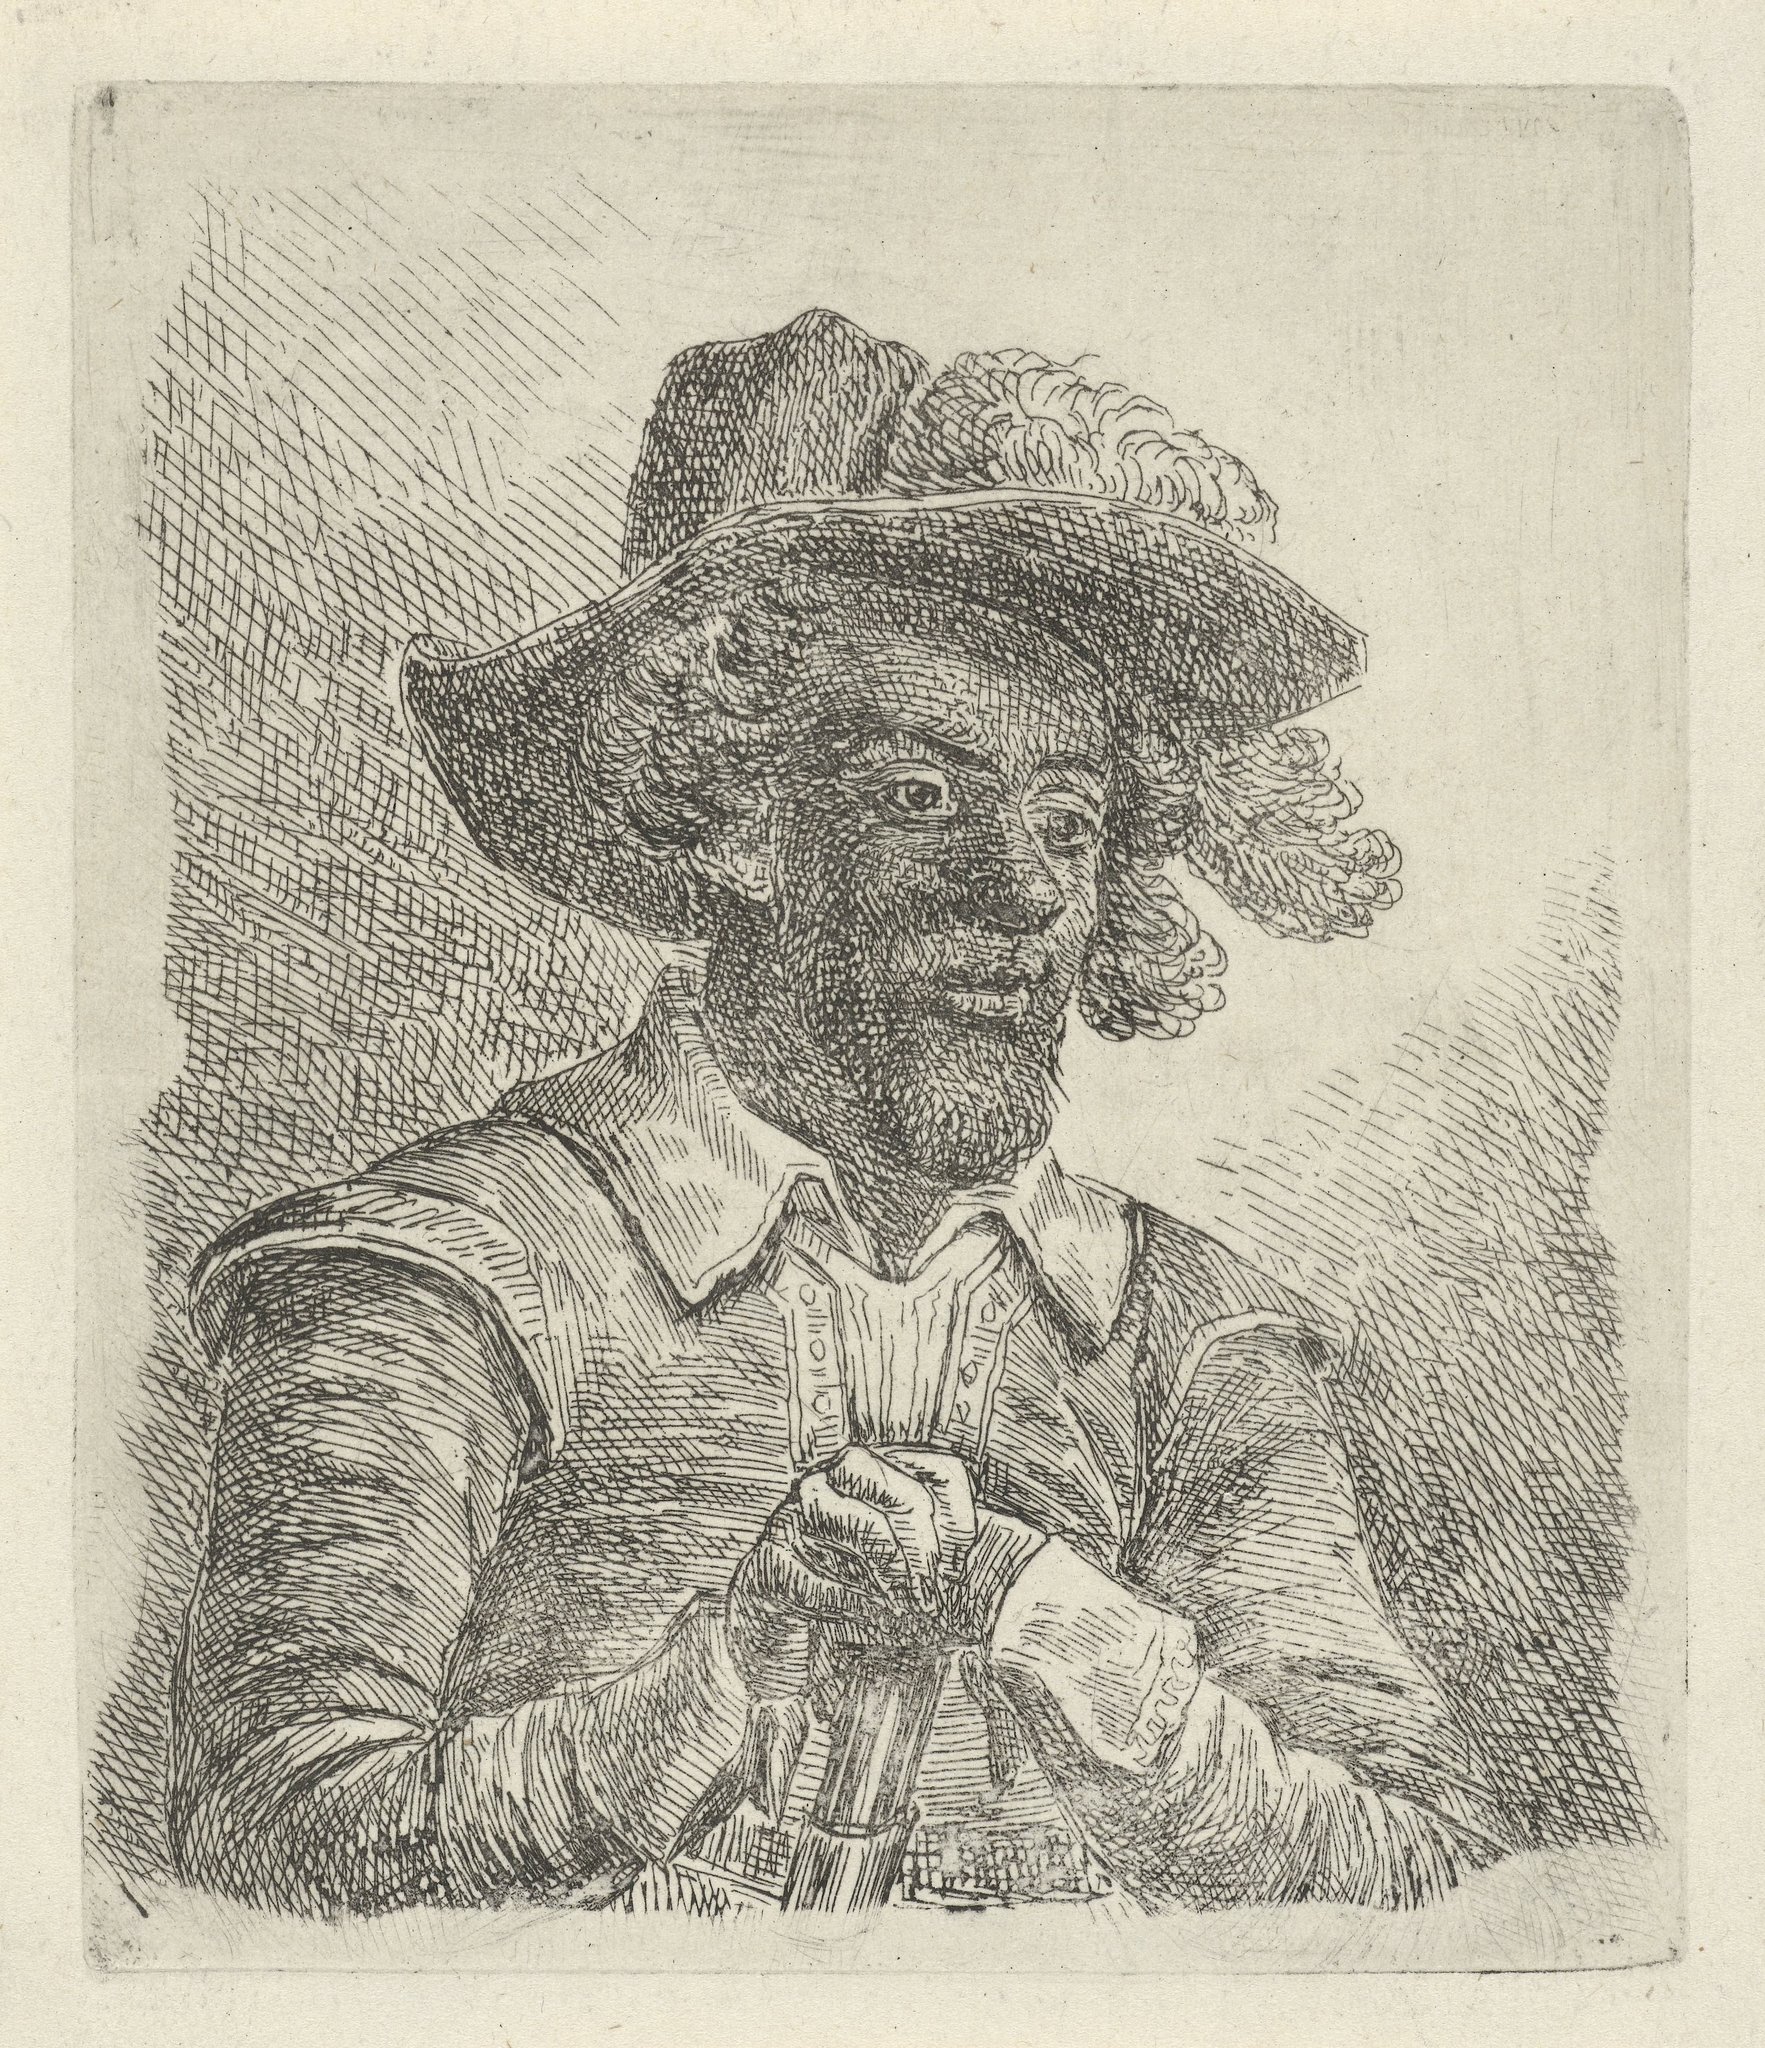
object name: print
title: Krijgsman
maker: christiaan kramm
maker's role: draughtsman, print maker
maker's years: 1797-1875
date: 1807-1875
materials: paper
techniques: etching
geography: utrecht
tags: the soldier; the soldier's life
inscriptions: collector's mark: Lugt 2228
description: Een krijgsman met een gevederde hoed op het hoofd. De man laat de handen rusten op de tromp van een geweer.